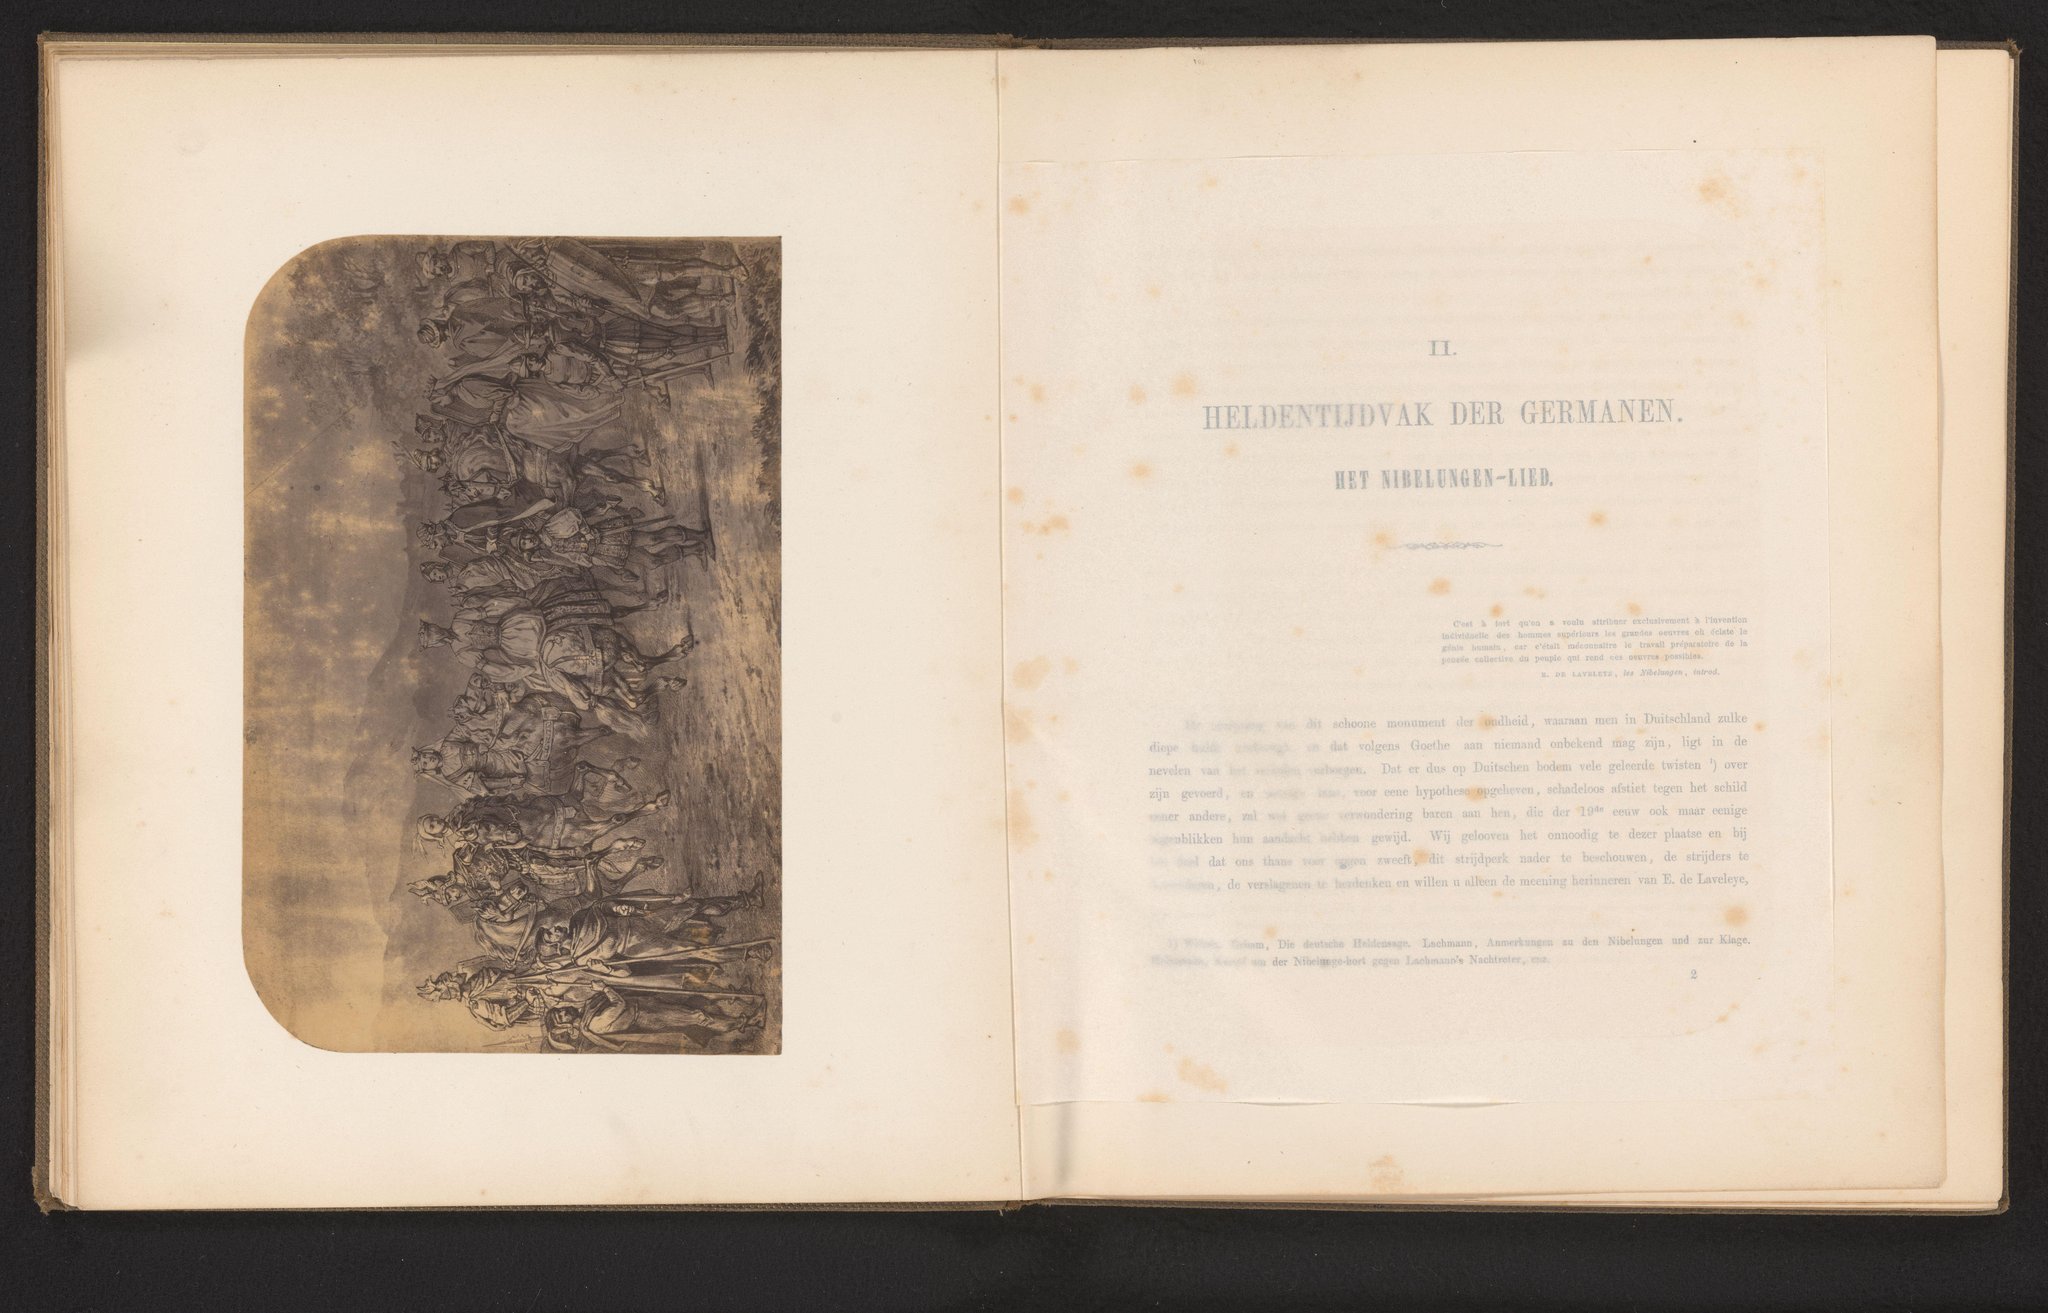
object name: reproduction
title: Fotoreproductie van een prent van een leger Germanen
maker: willem adrianus van hoek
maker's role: fotograaf, schrijver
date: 1856-1861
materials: paper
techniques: albumen print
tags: army 'en route', extinct, 'historical' peoples: teutons